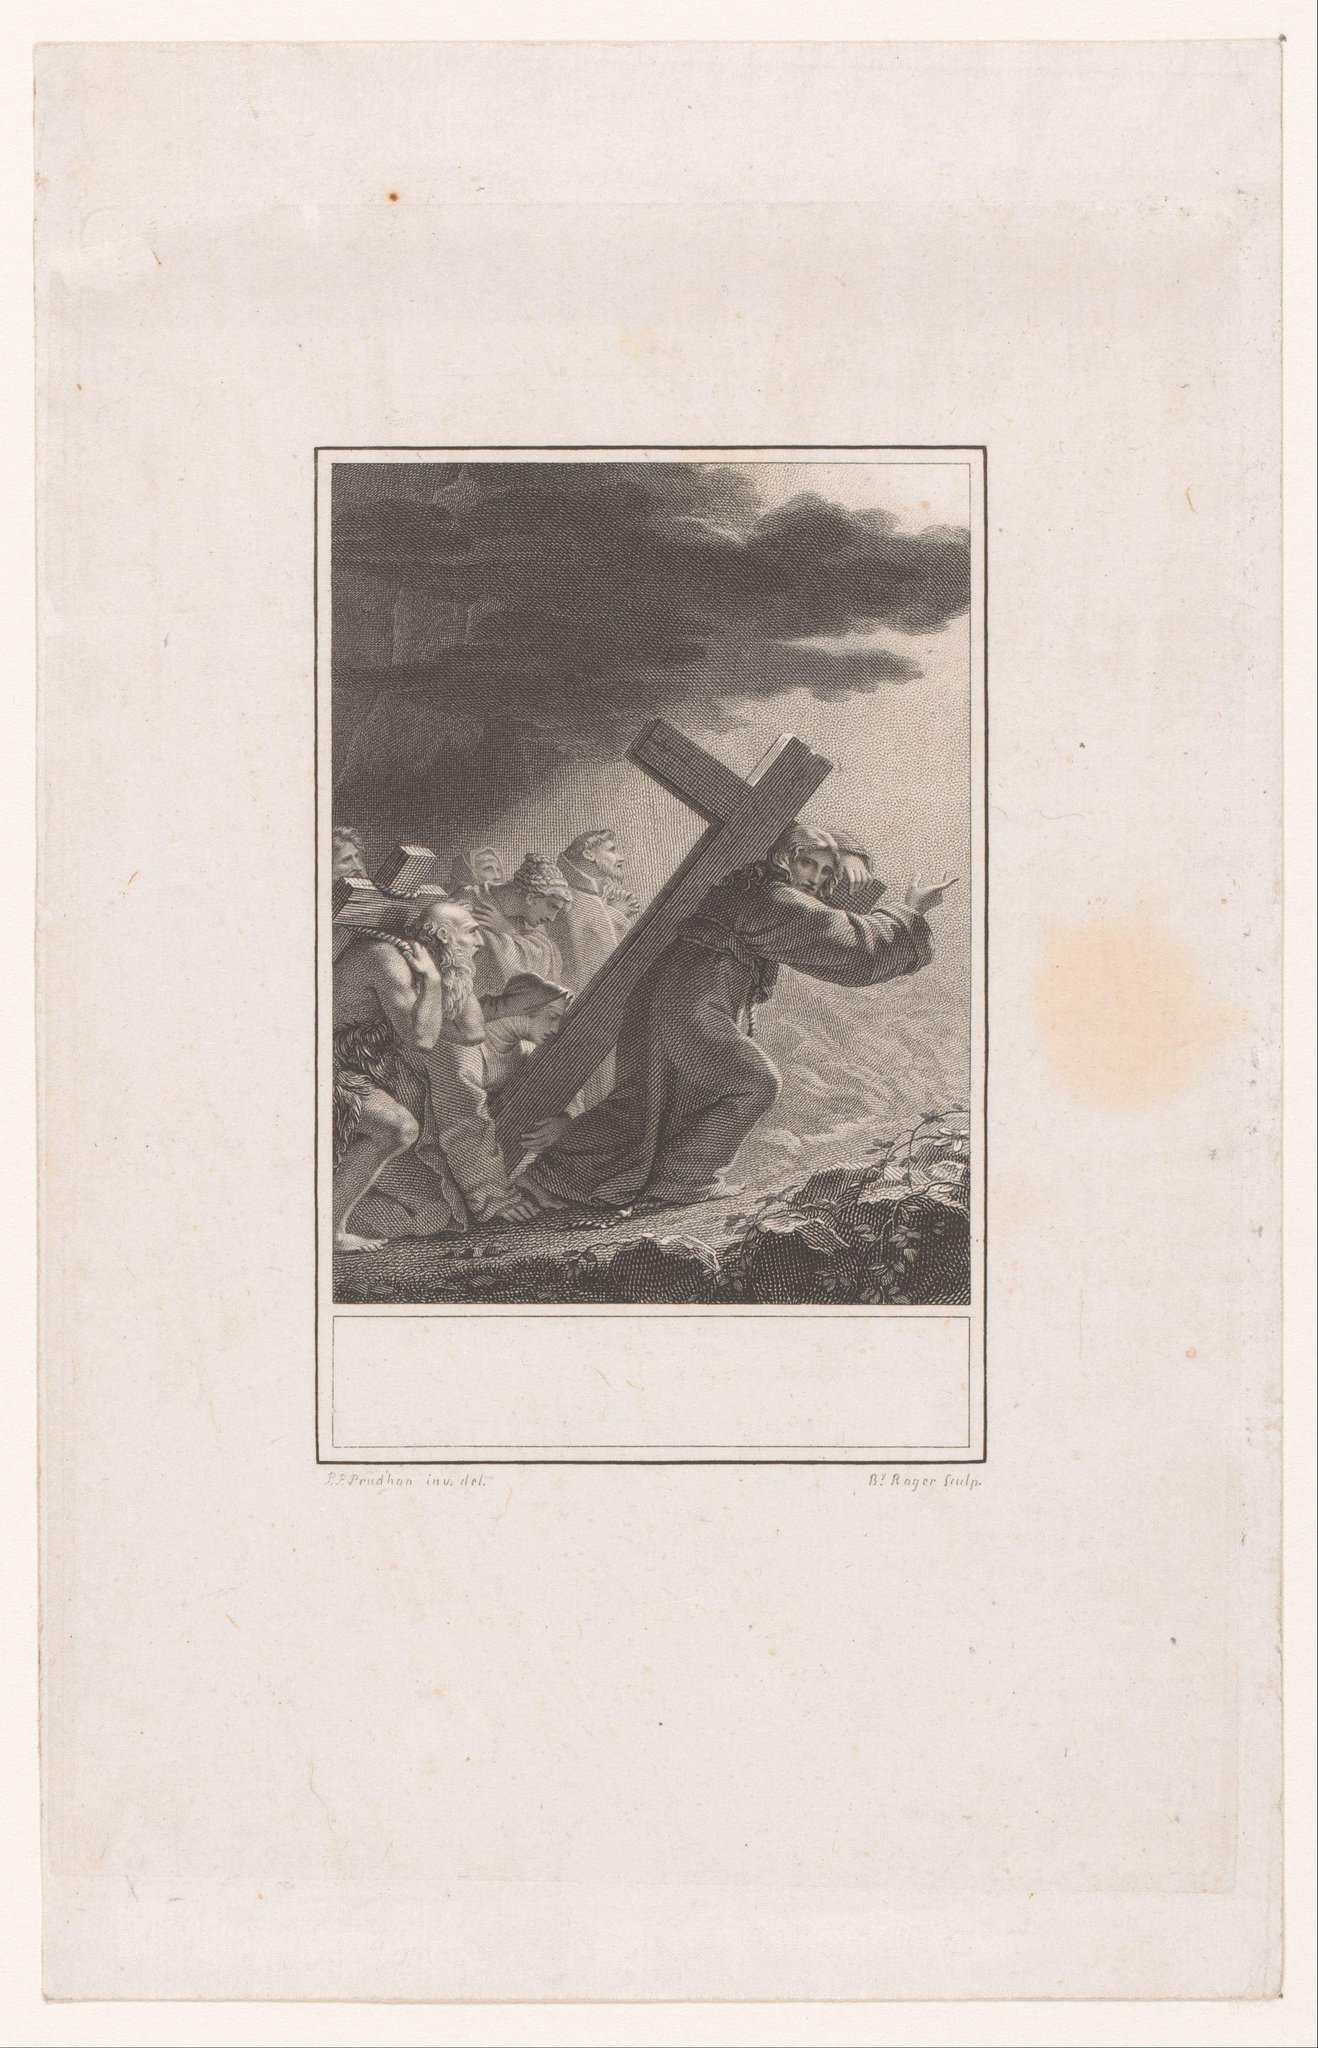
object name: print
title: Kruisdraging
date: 1817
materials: paper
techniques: engraving, etching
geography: paris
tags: carrying of the cross: christ bearing the cross, alone or with the help of others (e.g. simon the cyrenian)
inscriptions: collector's mark: Lugt 2228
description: Prent uit: Voltaire, François Marie Arouet de. Oeuvres de P. Corneille. Parijs: Antoine Augustin Renouard, 1817.